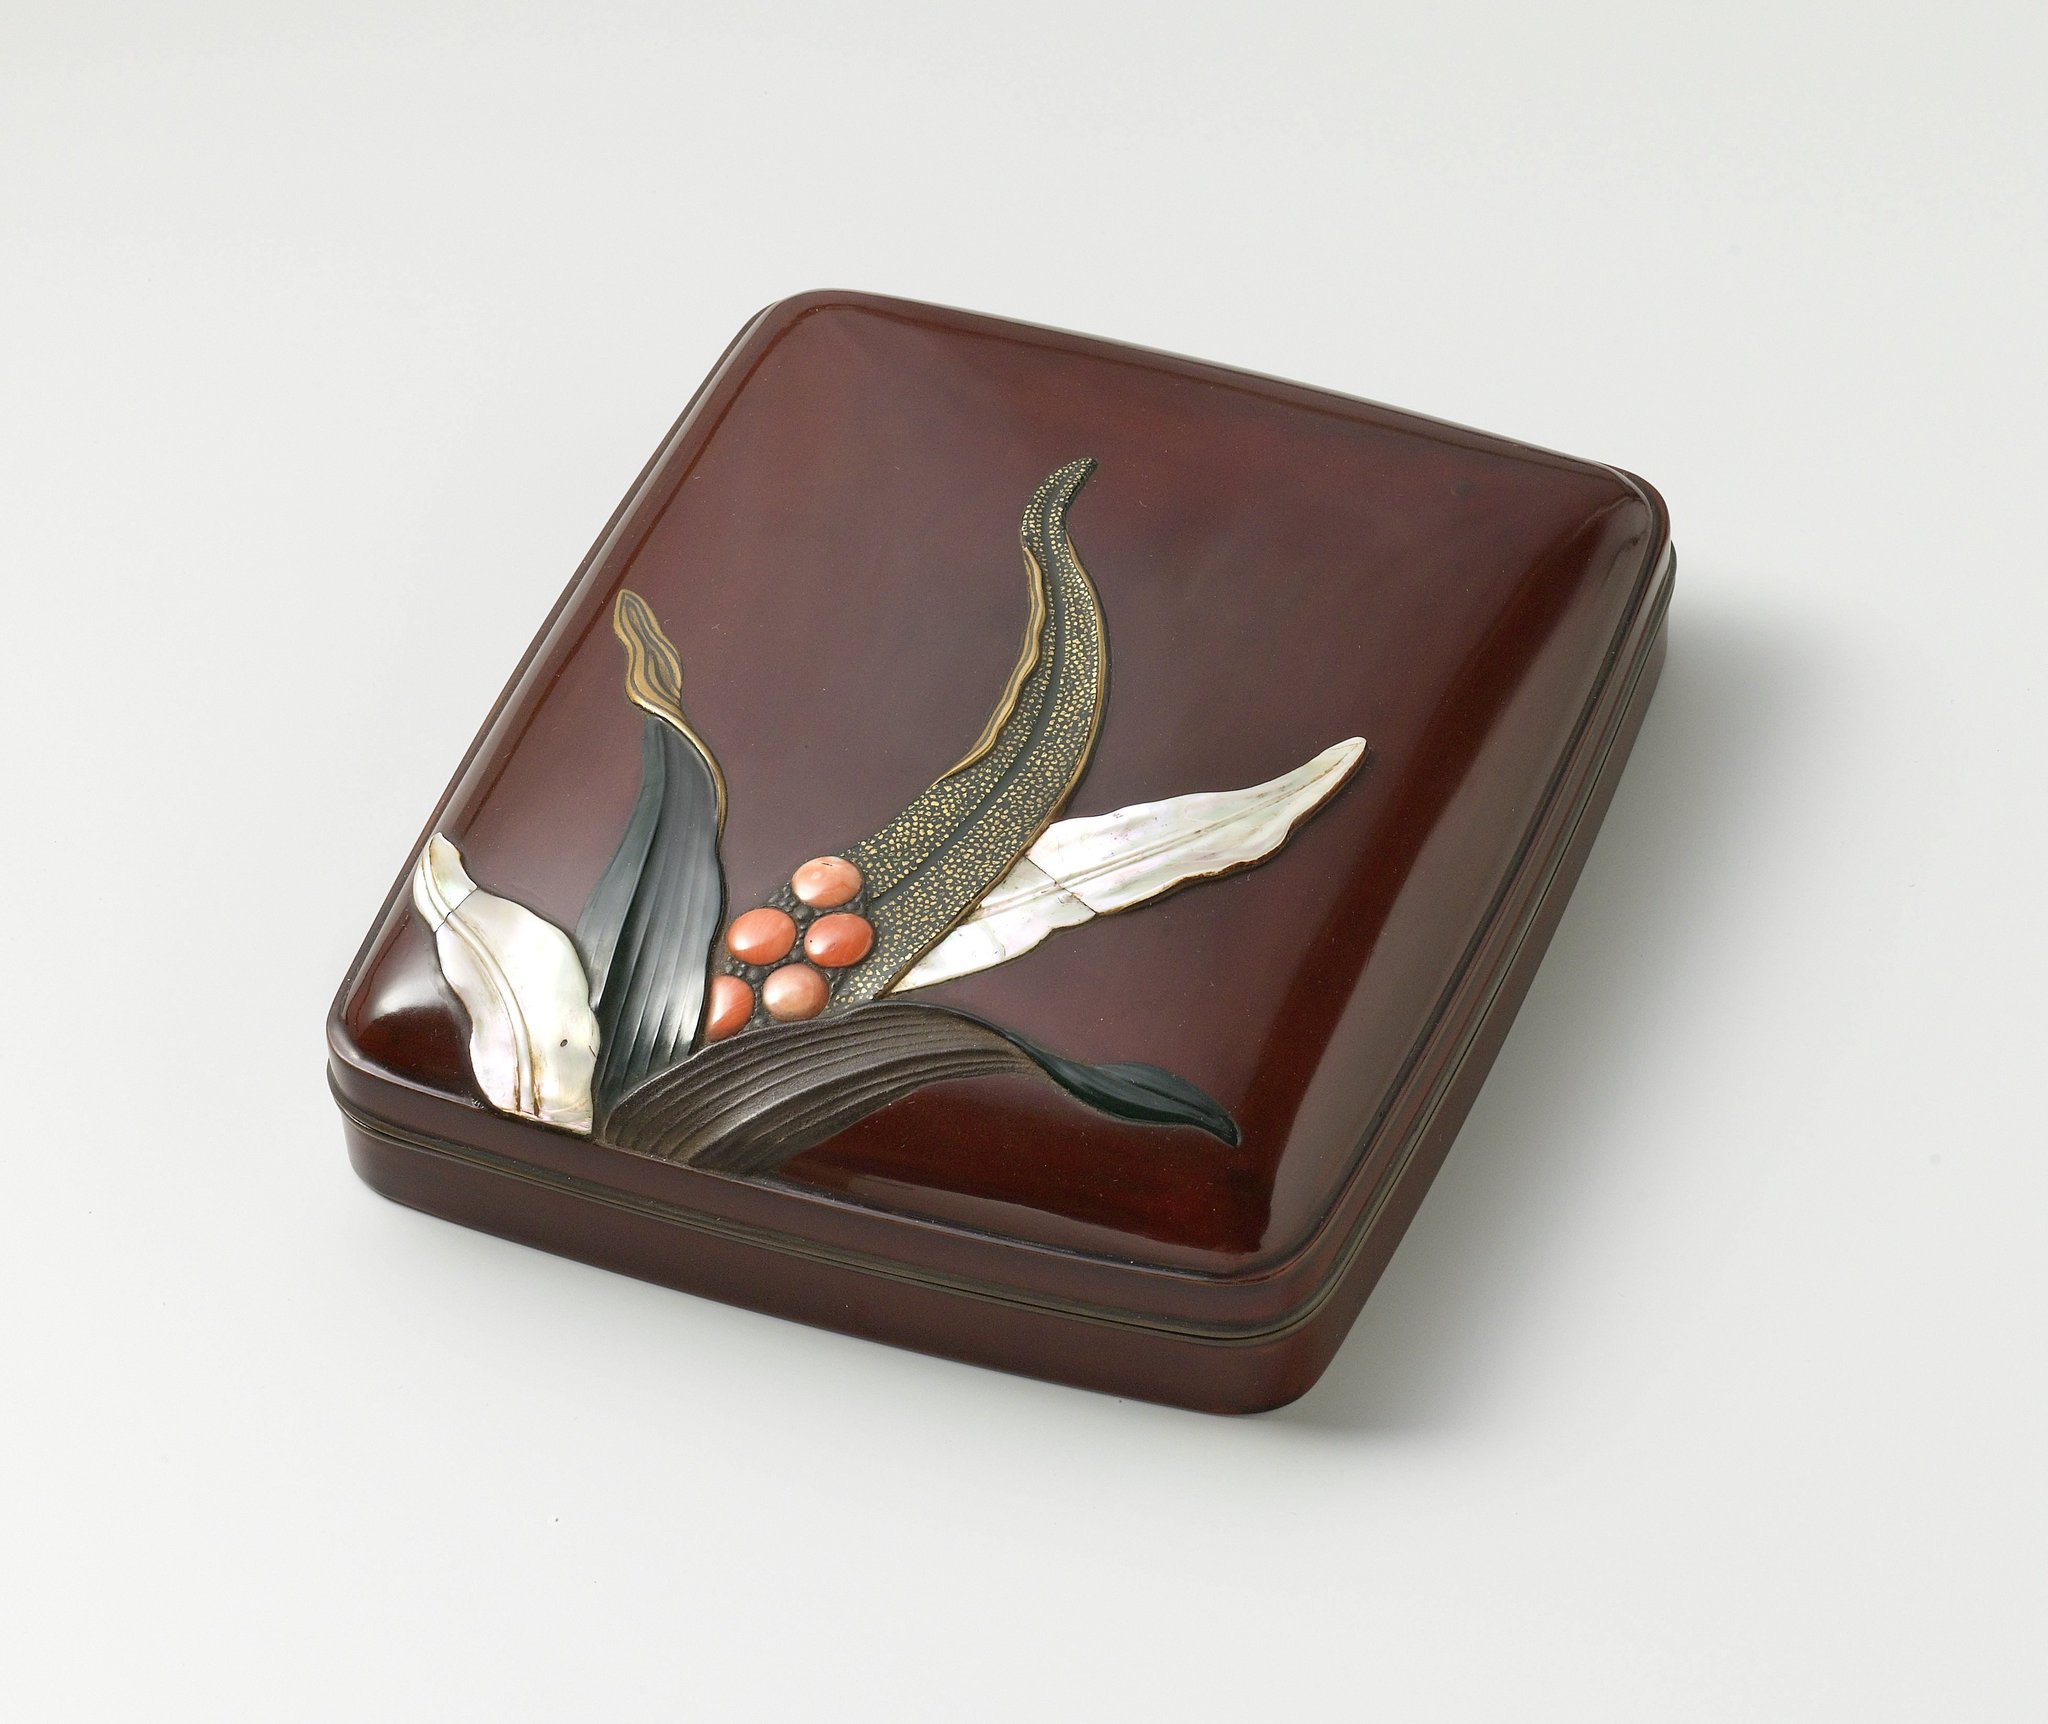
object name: suzuribako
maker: Anonymous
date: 1800-1900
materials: lacquer, wood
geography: japan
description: Writing box with a decoration of omoto (Rhodea Japonica). Japan. Early 19th Century. Lacquer with inlay. Westendorp bequest.